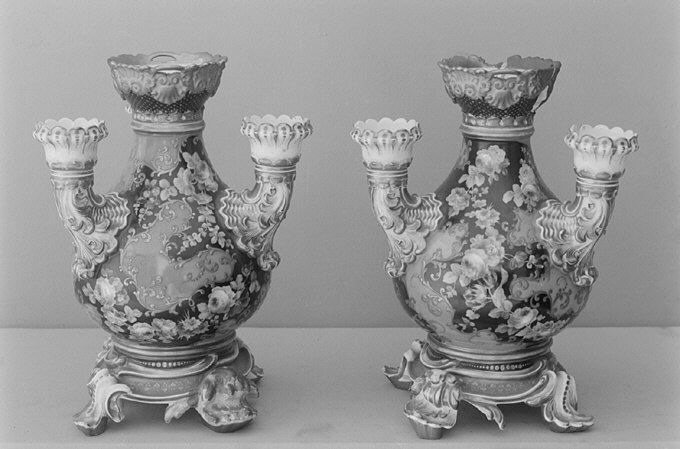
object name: flower vase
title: Pair of flower vases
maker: fontainebleau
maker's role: factory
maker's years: 1530-1700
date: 1834-1840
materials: hard paste porcelain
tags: flowers